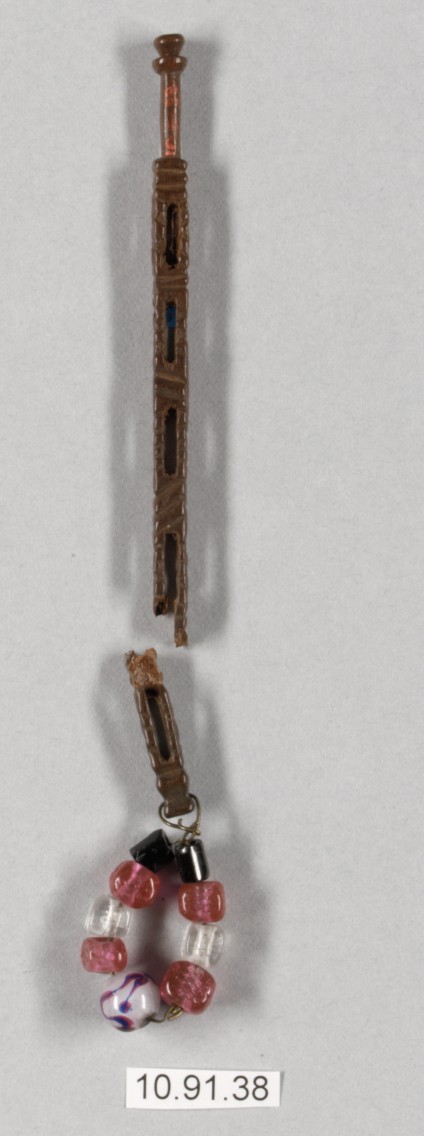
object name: bobbin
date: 1801-1900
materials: wood